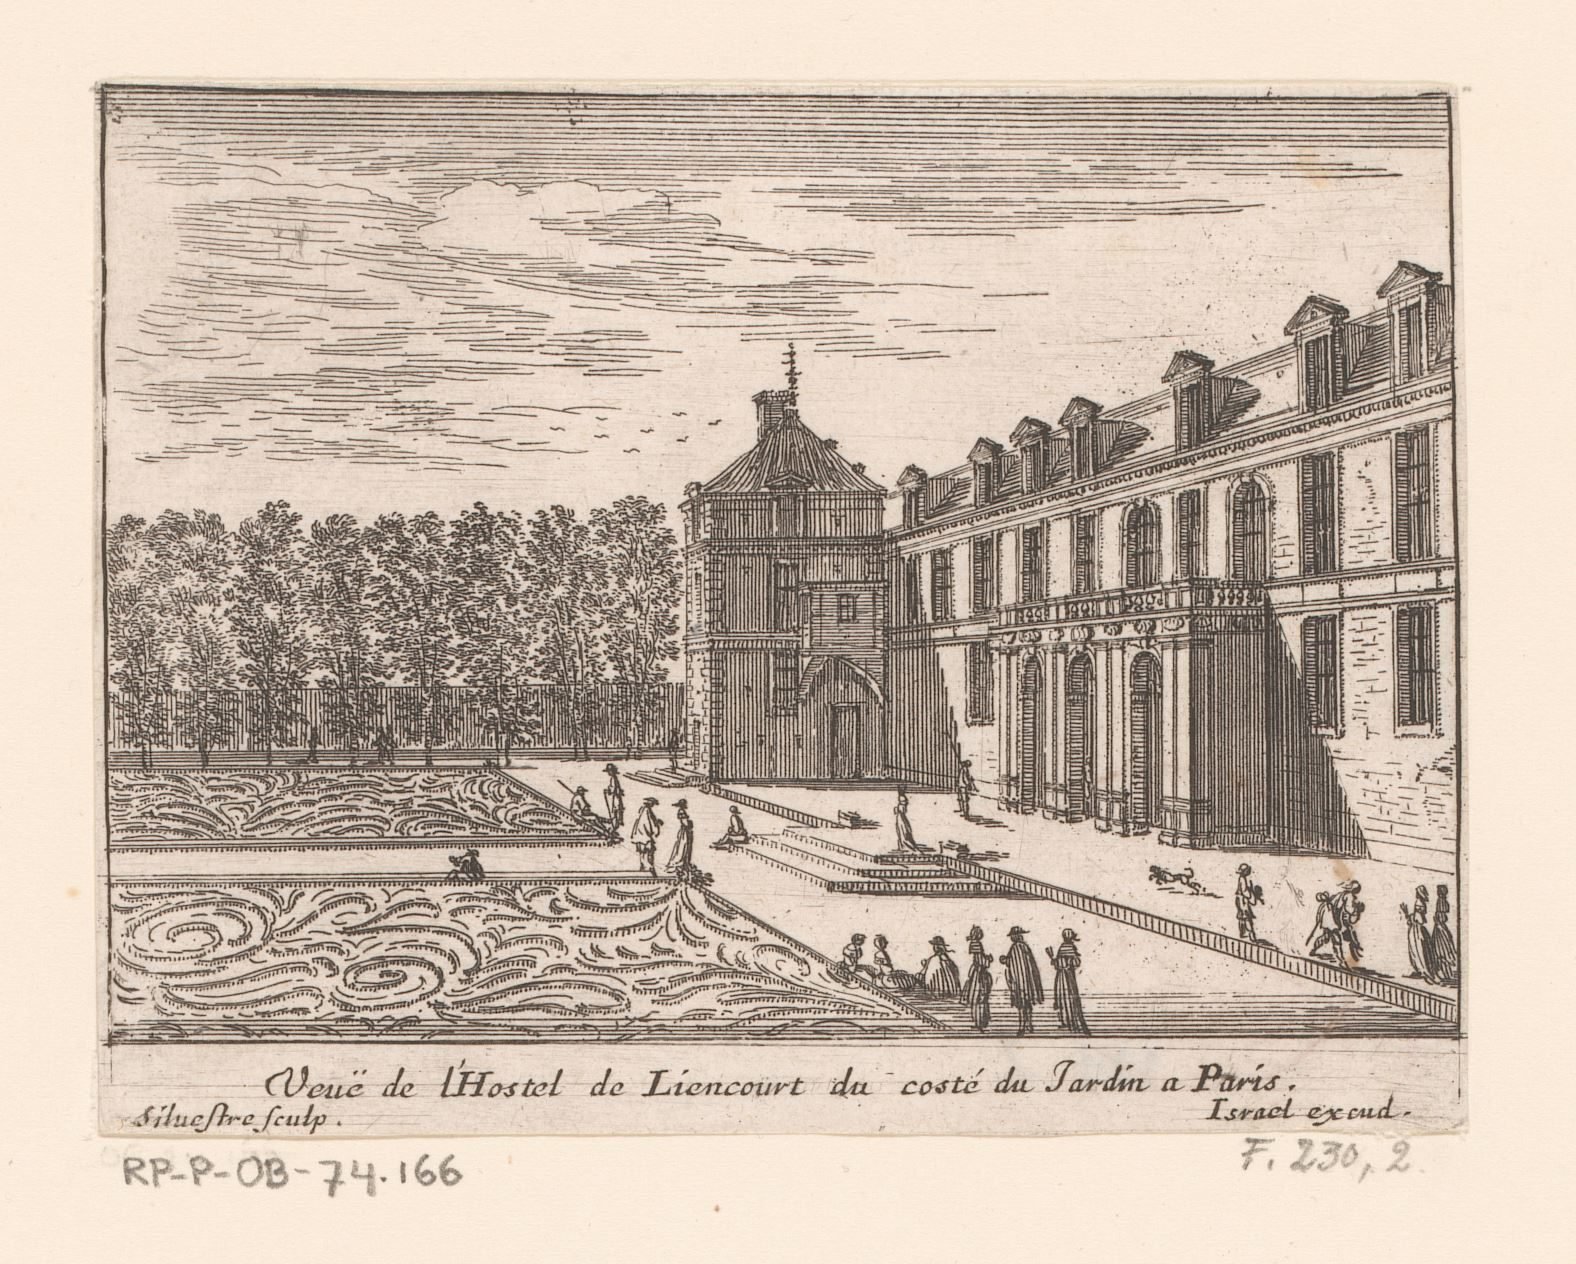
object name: print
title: Gezichten op het kasteel van Rochefoucauld in Liancourt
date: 1631-1661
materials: paper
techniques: etching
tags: french or architectonic garden; formal garden, landscape with tower or castle (+ city(-scape) with figures, staffage), paris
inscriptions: collector's mark: Lugt 240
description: Prent maakt deel uit van een ongenummerde serie van negen prenten.